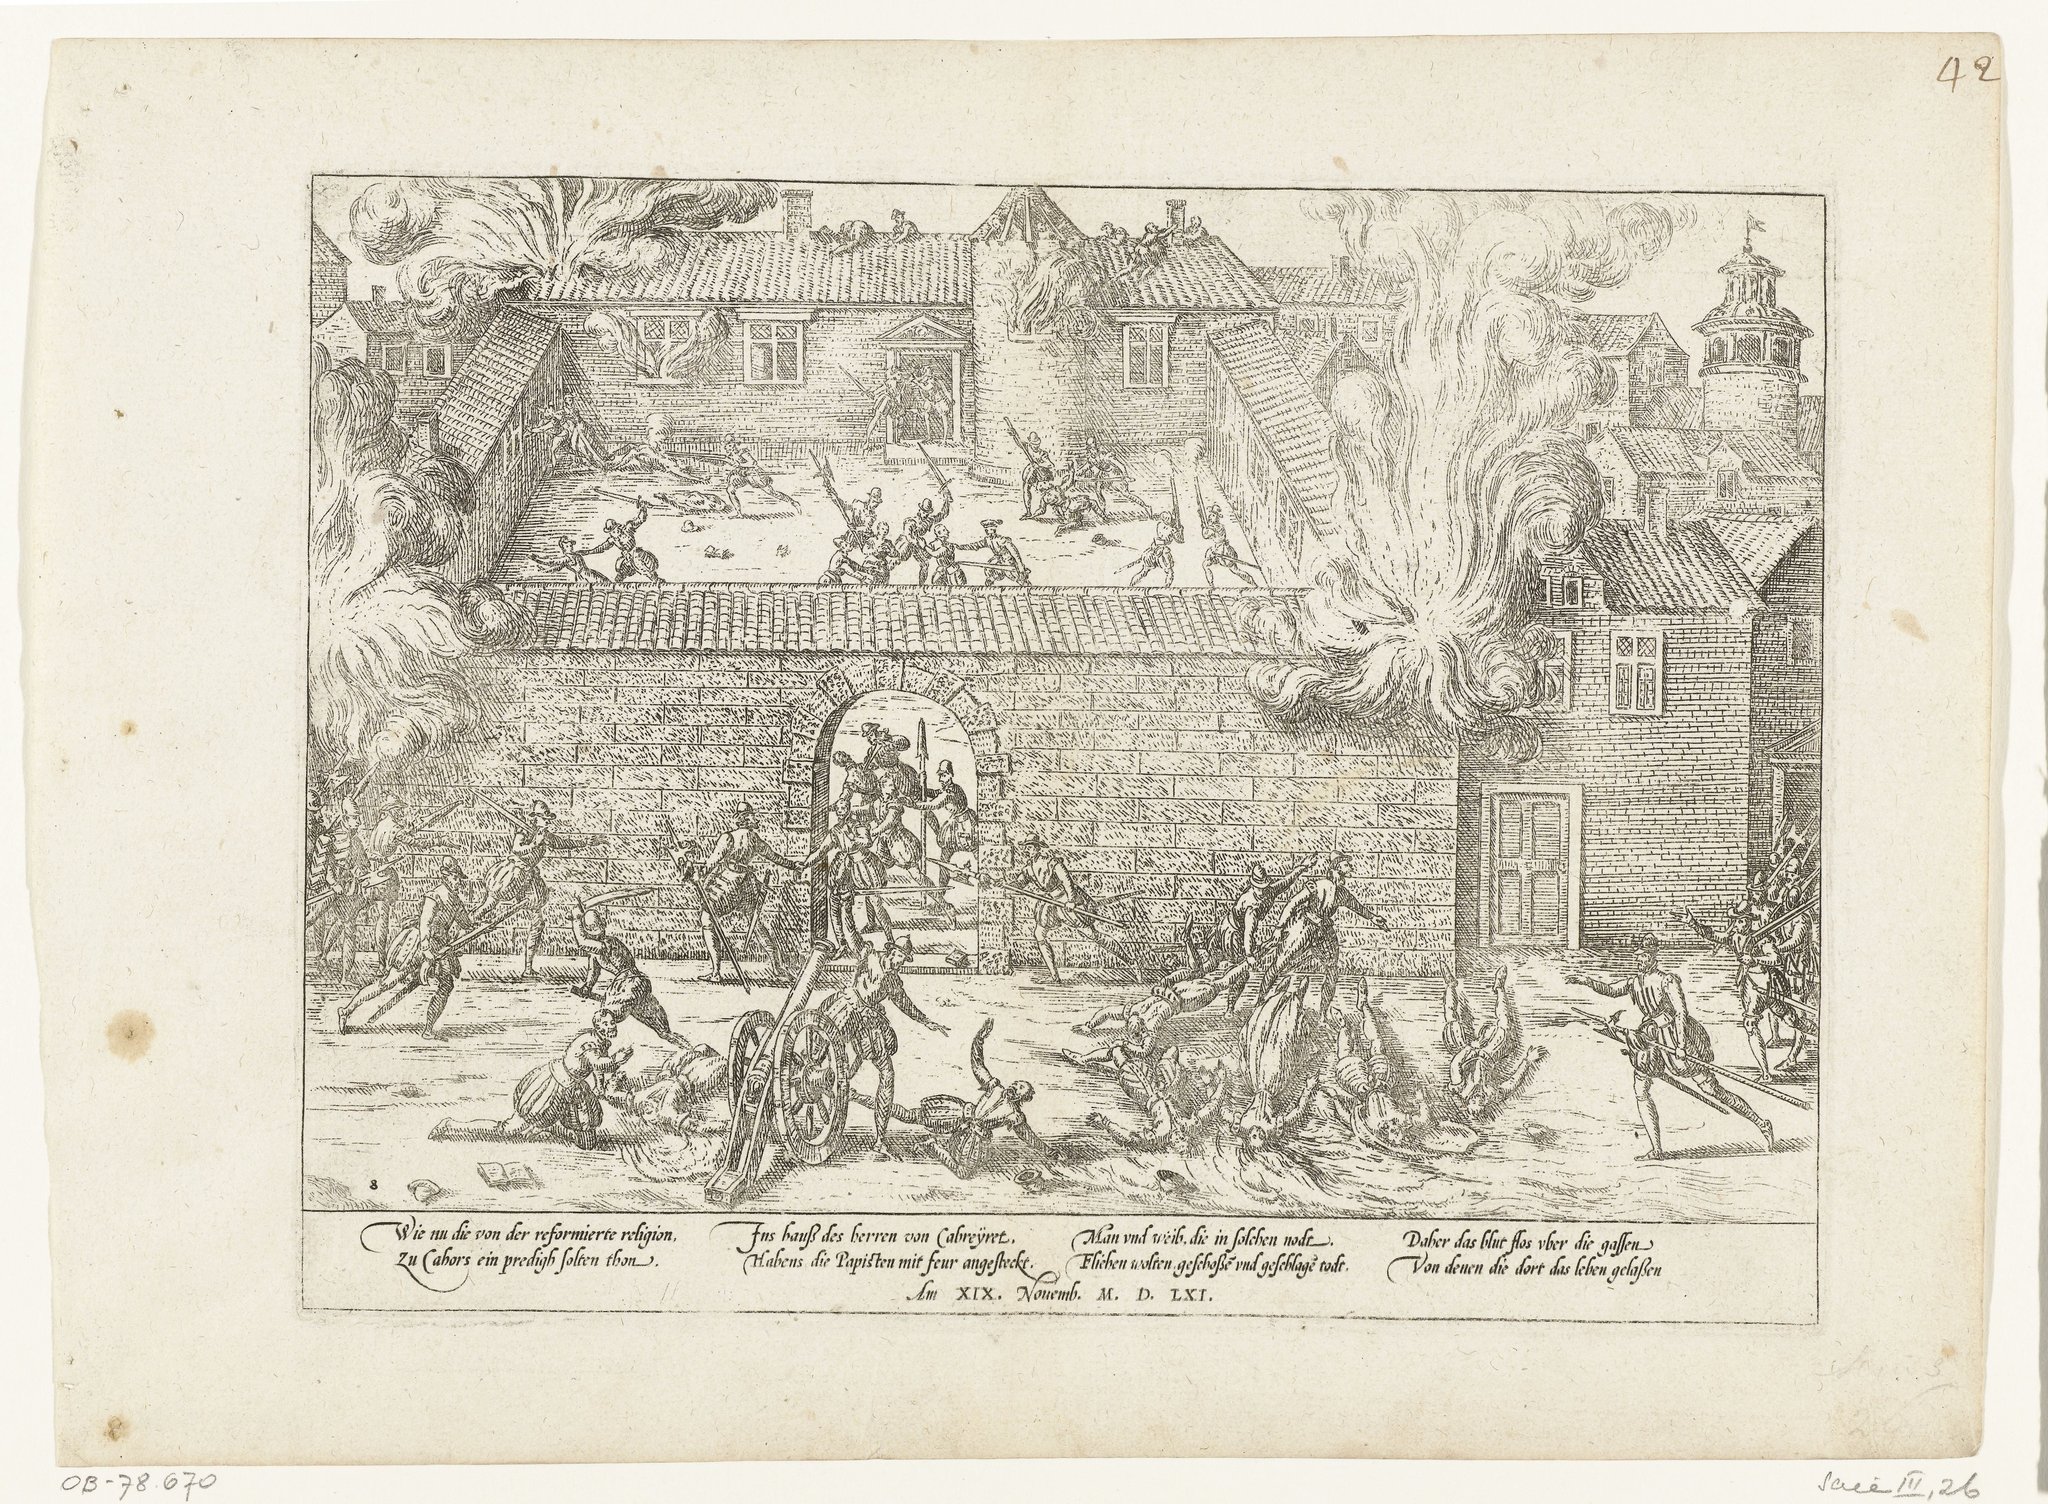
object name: history print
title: Moord op de protestanten te Cahors, 1561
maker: frans hogenberg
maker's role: print maker, publisher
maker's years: 1538-1590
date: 1565-1573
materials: paper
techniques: etching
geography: cologne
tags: massacre ~ war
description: Gekopieerd naar de prent in: Jean Tortorel et Jacques Perrissin, Premier volume contenant quarante tableaux ou Histoires diverses qui sont memorables touchant les Guerres, Massacres et Troubles advenus en France en ces dernieres annees : le tout recueilly selon le tesmoignange de ceux qui y ont esté en personne et qui les ont veus : lesquels sont pourtraits à la vérité, Genève ca. 1570. Bibliotheek Rijksmuseum: 329 A 2, pl. 9.